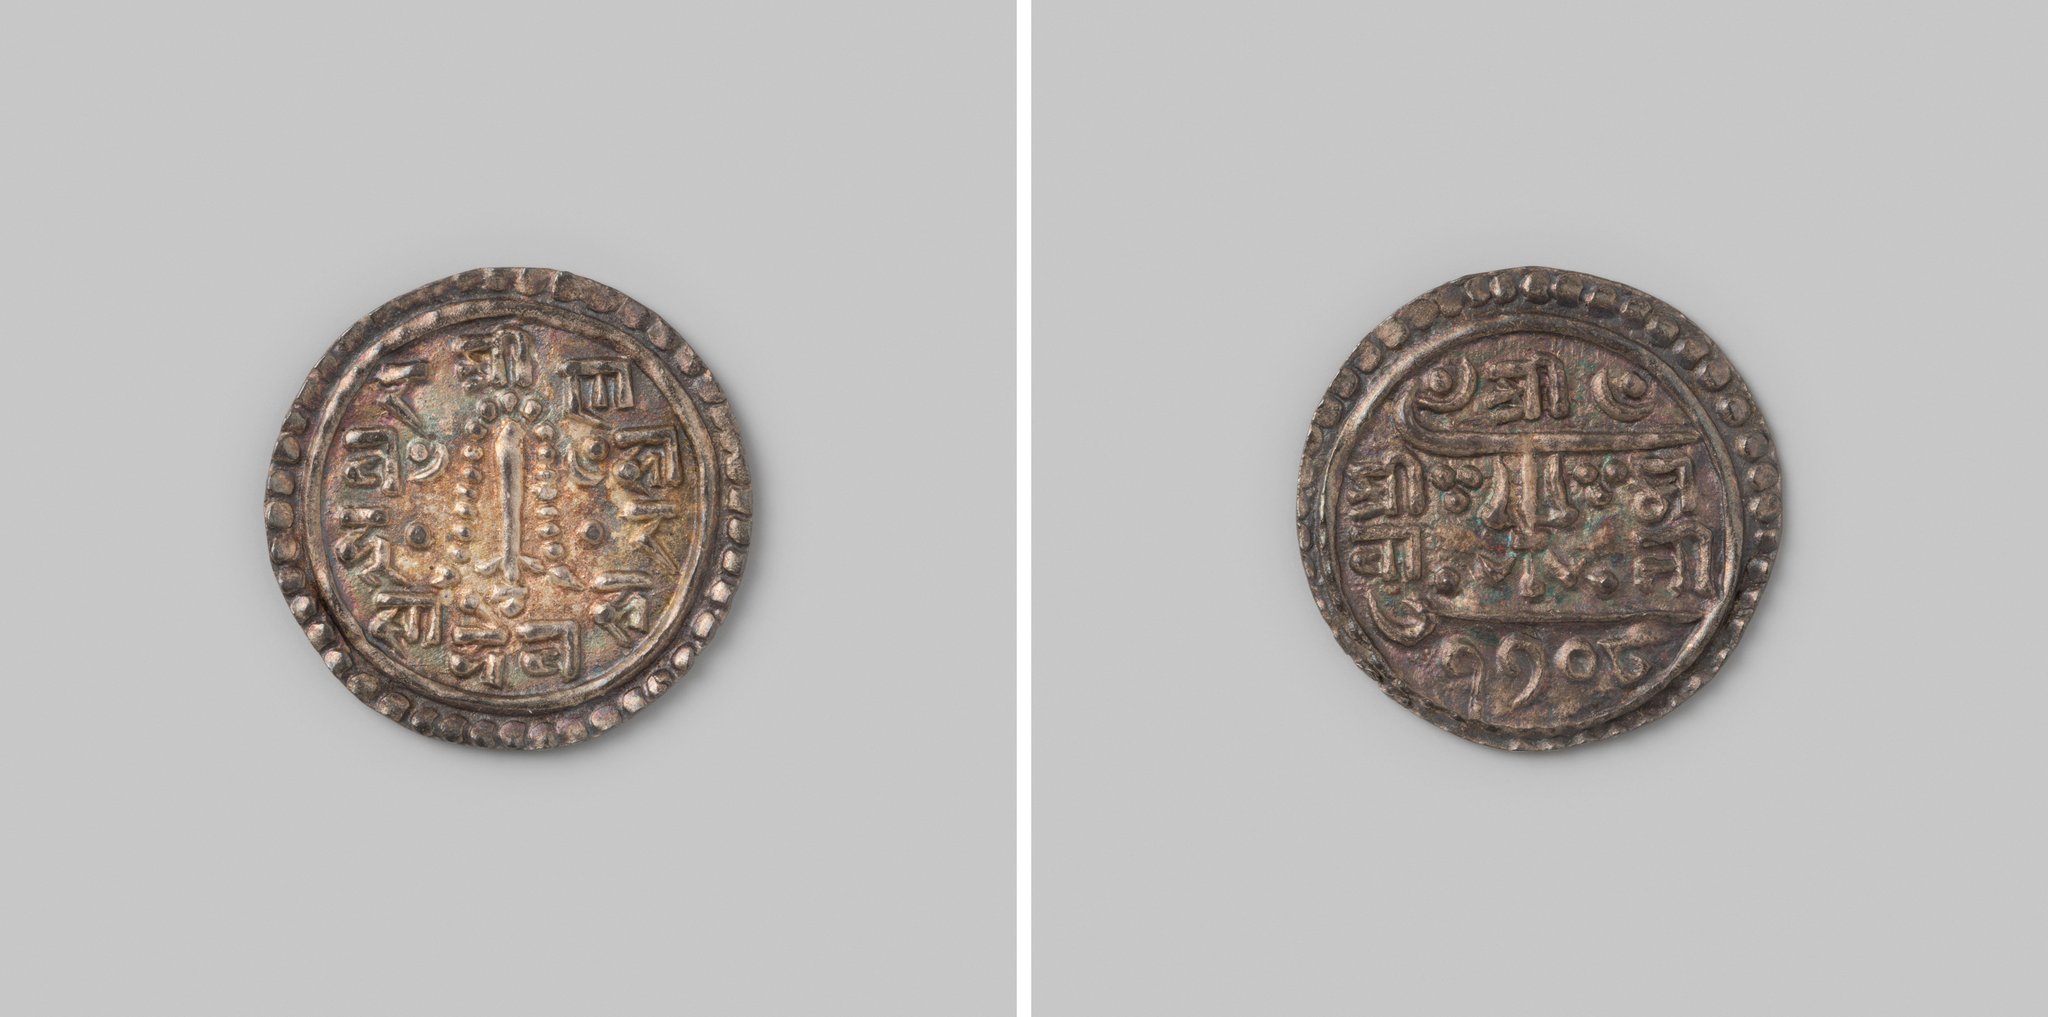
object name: coin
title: Nepal, 1/4 mohar, 1787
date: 1787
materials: silver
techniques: striking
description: Zilveren munt. Voorzijde: rondom stupa tekens in Nagari-schrift. Keerzijde: drietand, waaromheen tekens in Nagari-schrift. Jaartal onderaan. Gladde rand.